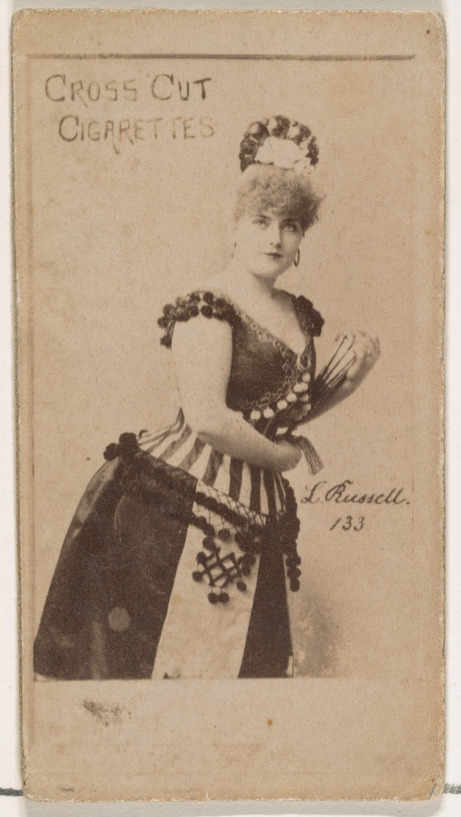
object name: print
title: Card Number 133, Lillian Russell, from the Actors and Actresses series (N145-1) issued by Duke Sons & Co. to promote Cross Cut Cigarettes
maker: w. duke, sons & co.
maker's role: publisher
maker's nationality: american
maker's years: 1870-1920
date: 1880-1889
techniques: albumen silver print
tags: portraits,women,actresses